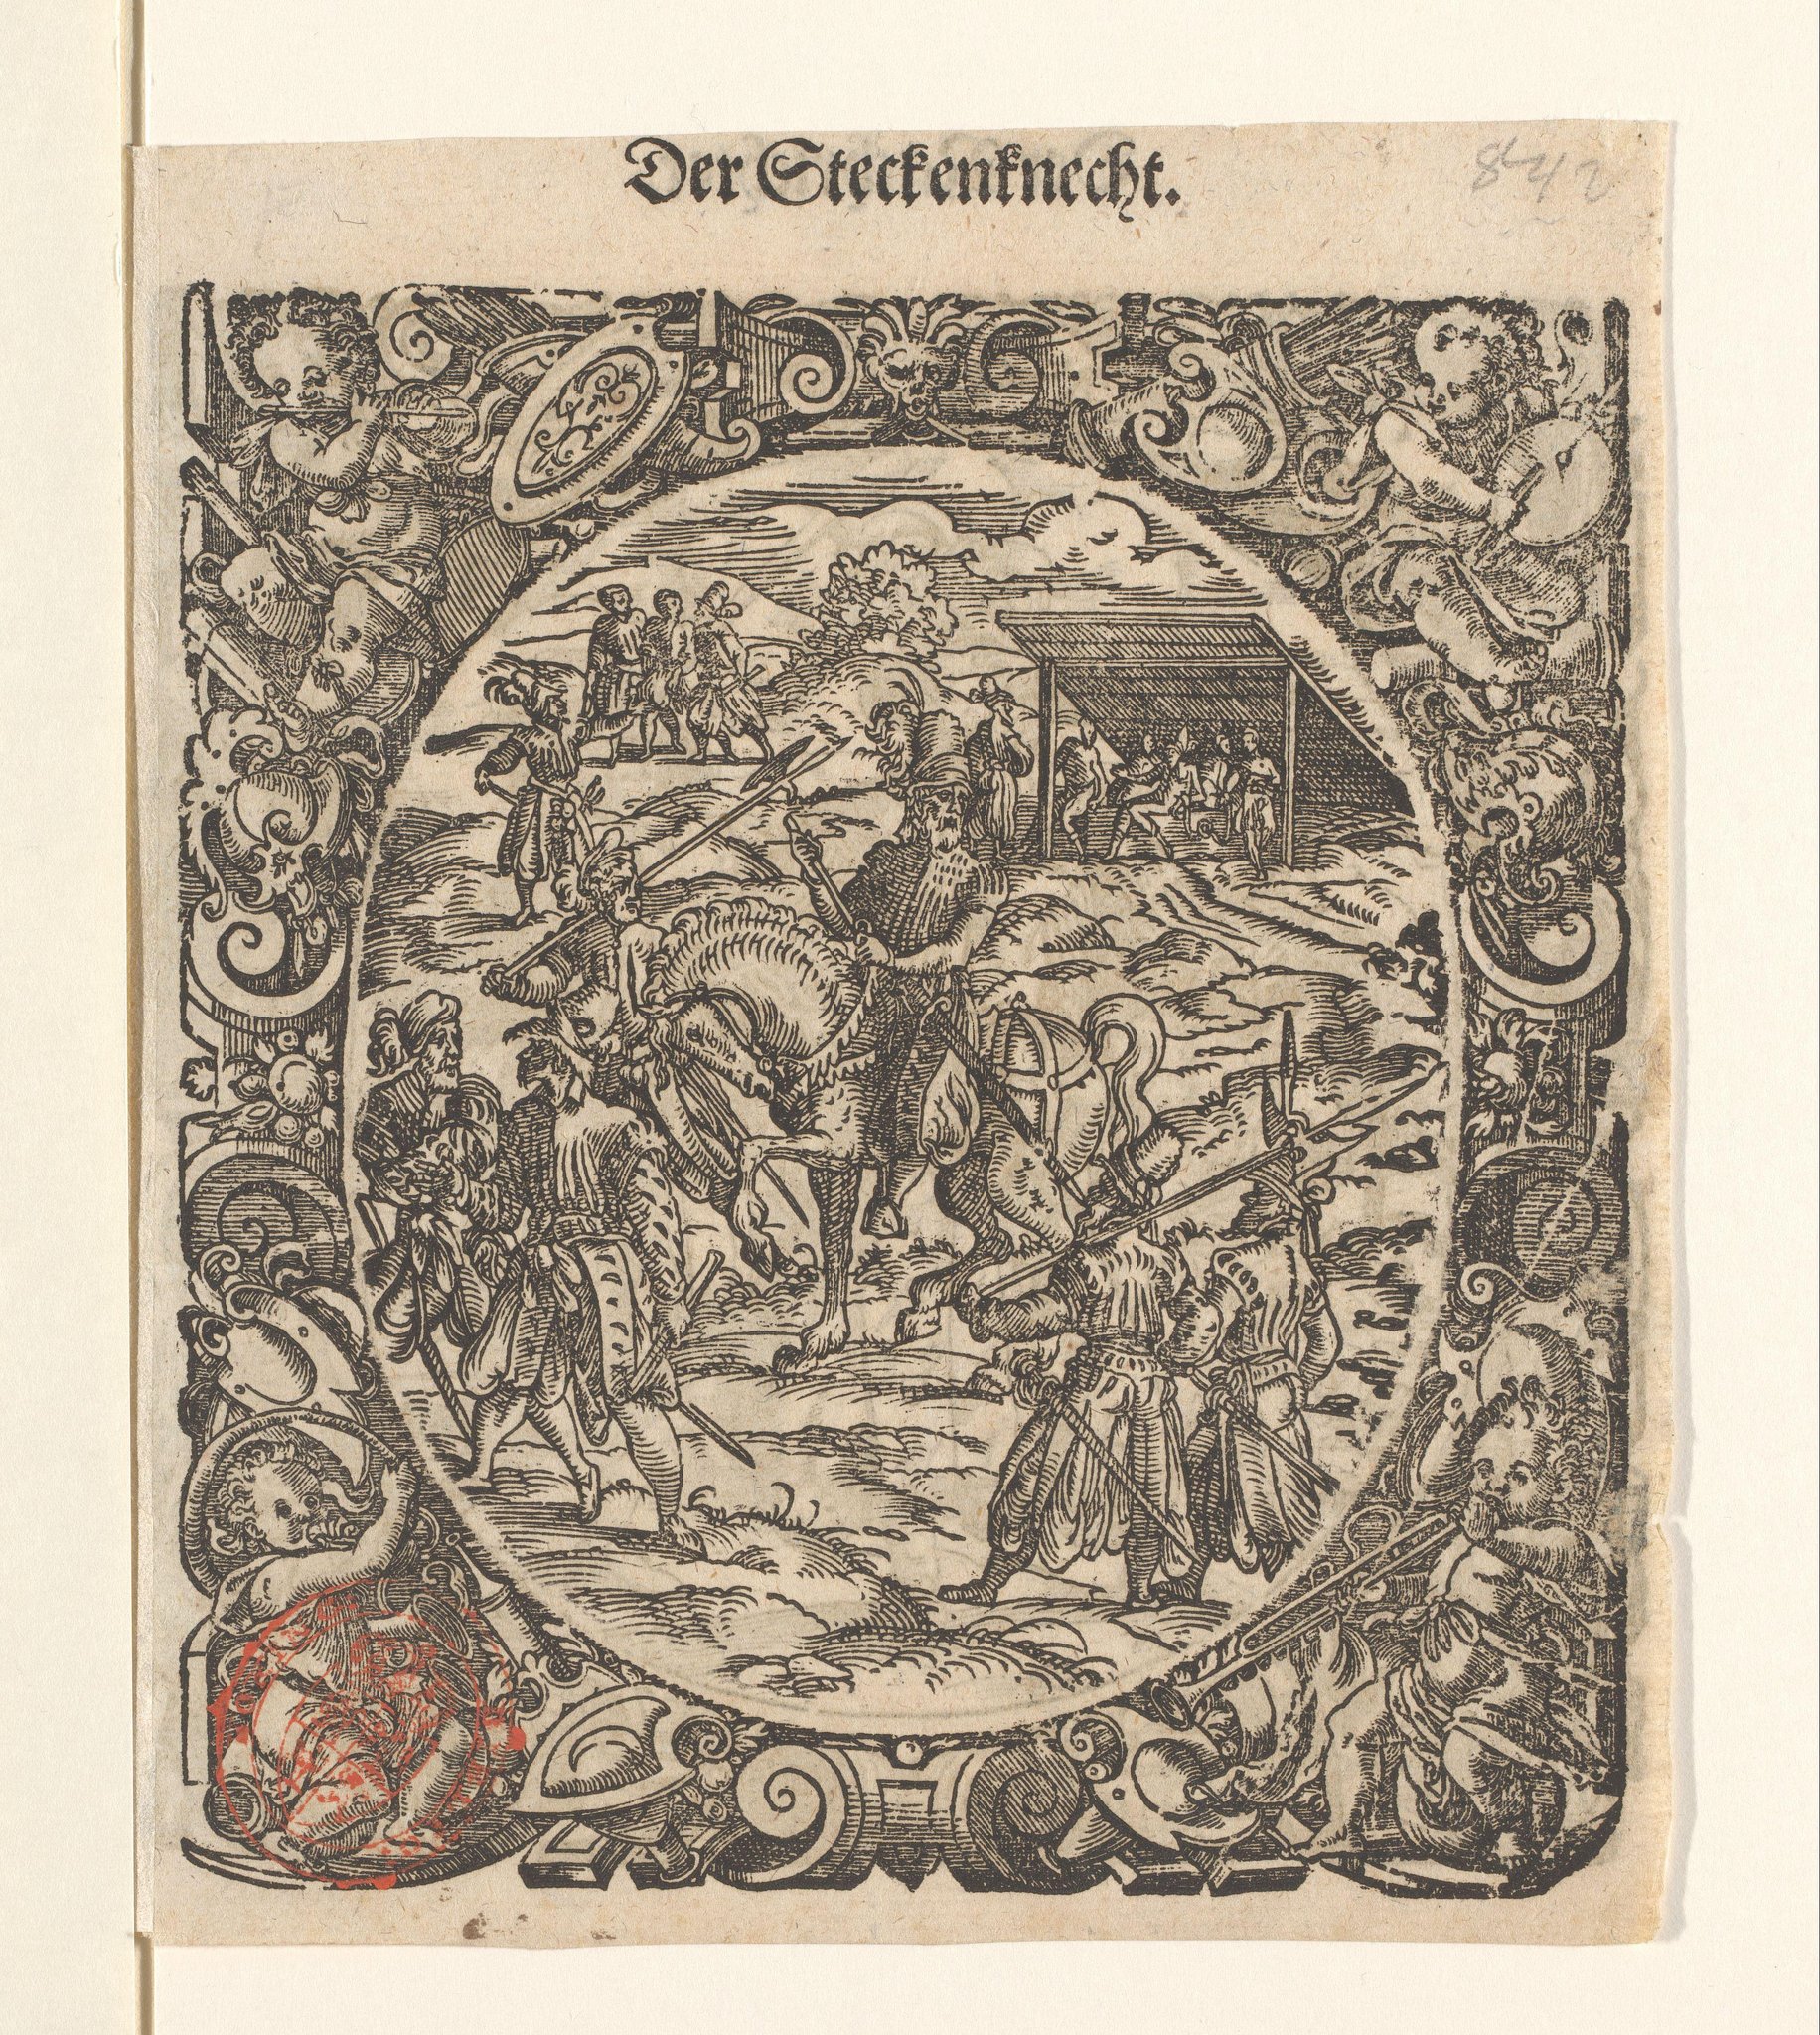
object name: print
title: Der Steckenknecht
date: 1573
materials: paper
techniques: woodcut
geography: frankfurt am main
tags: riding a horse, ass, or mule; rider, horseman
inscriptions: collector's mark: Lugt 240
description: Zowel de voorstelling als de ornamentrand werd gebruikt voor verschillende edities van Leonhardt Fronspergers Kriegsbuch.